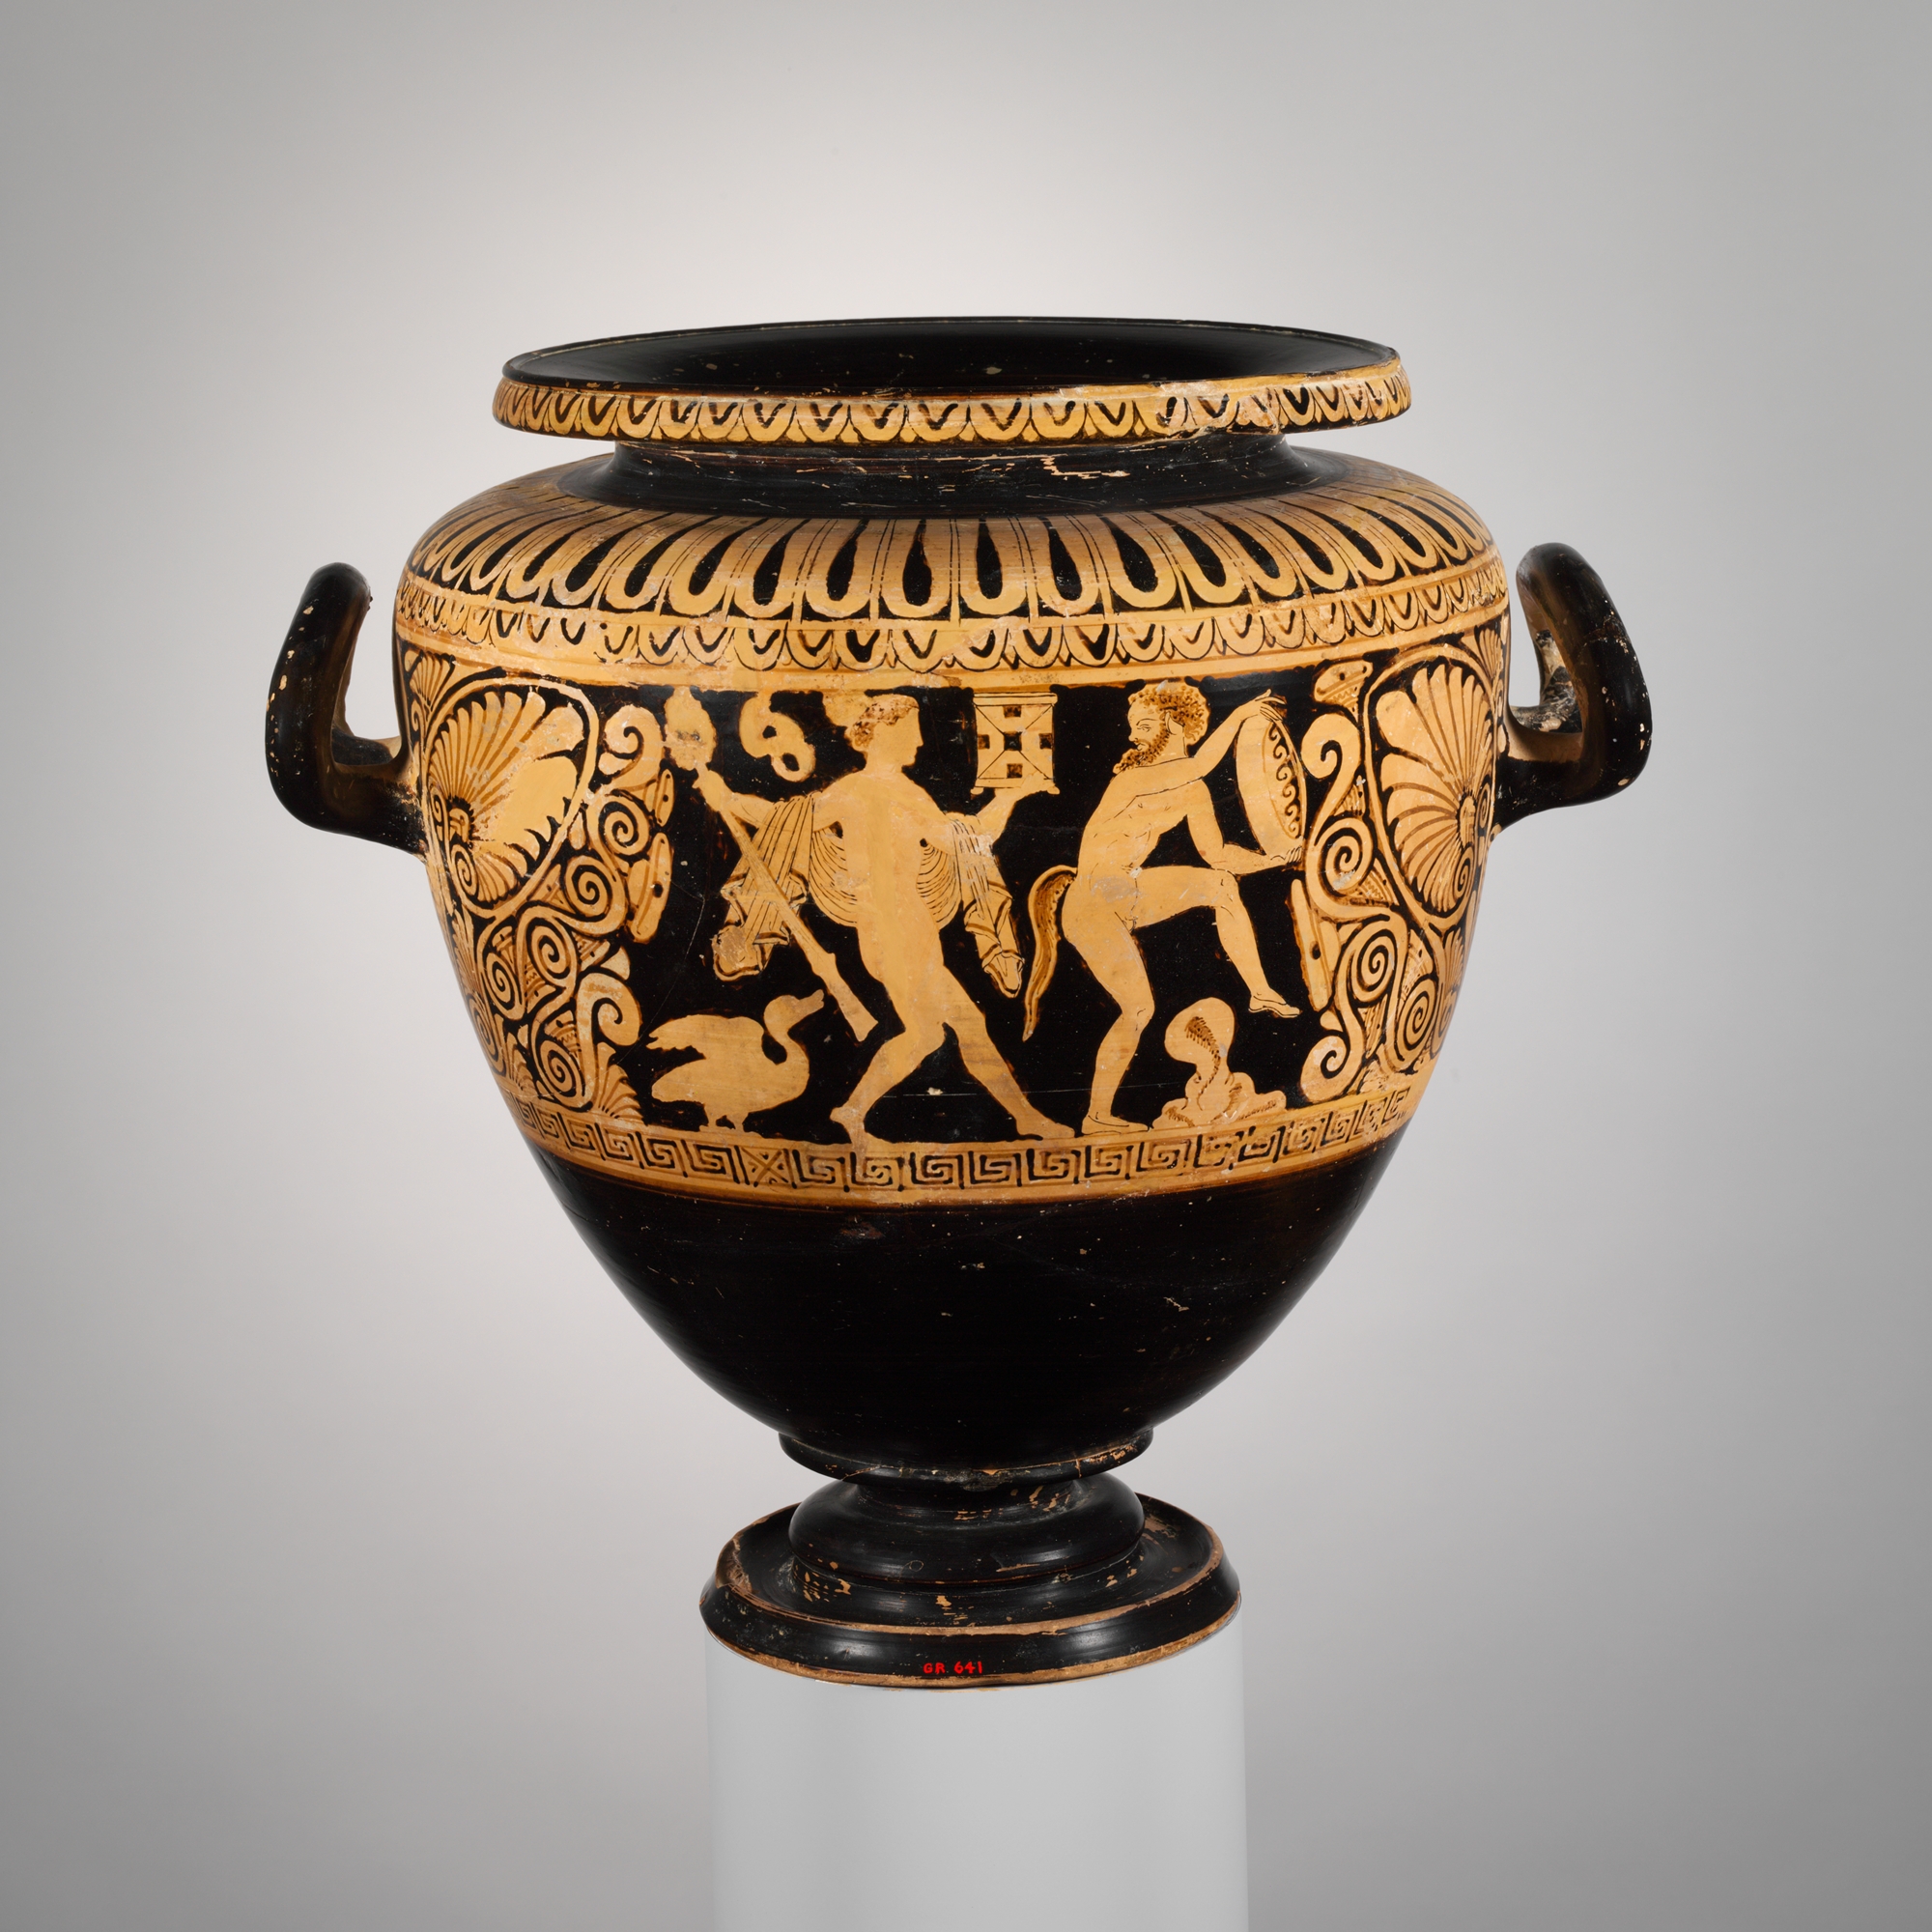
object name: stamnos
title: Terracotta stamnos (jar)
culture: faliscan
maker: captives group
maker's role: artist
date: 350 BCE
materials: terracotta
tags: birds,maenads,satyrs